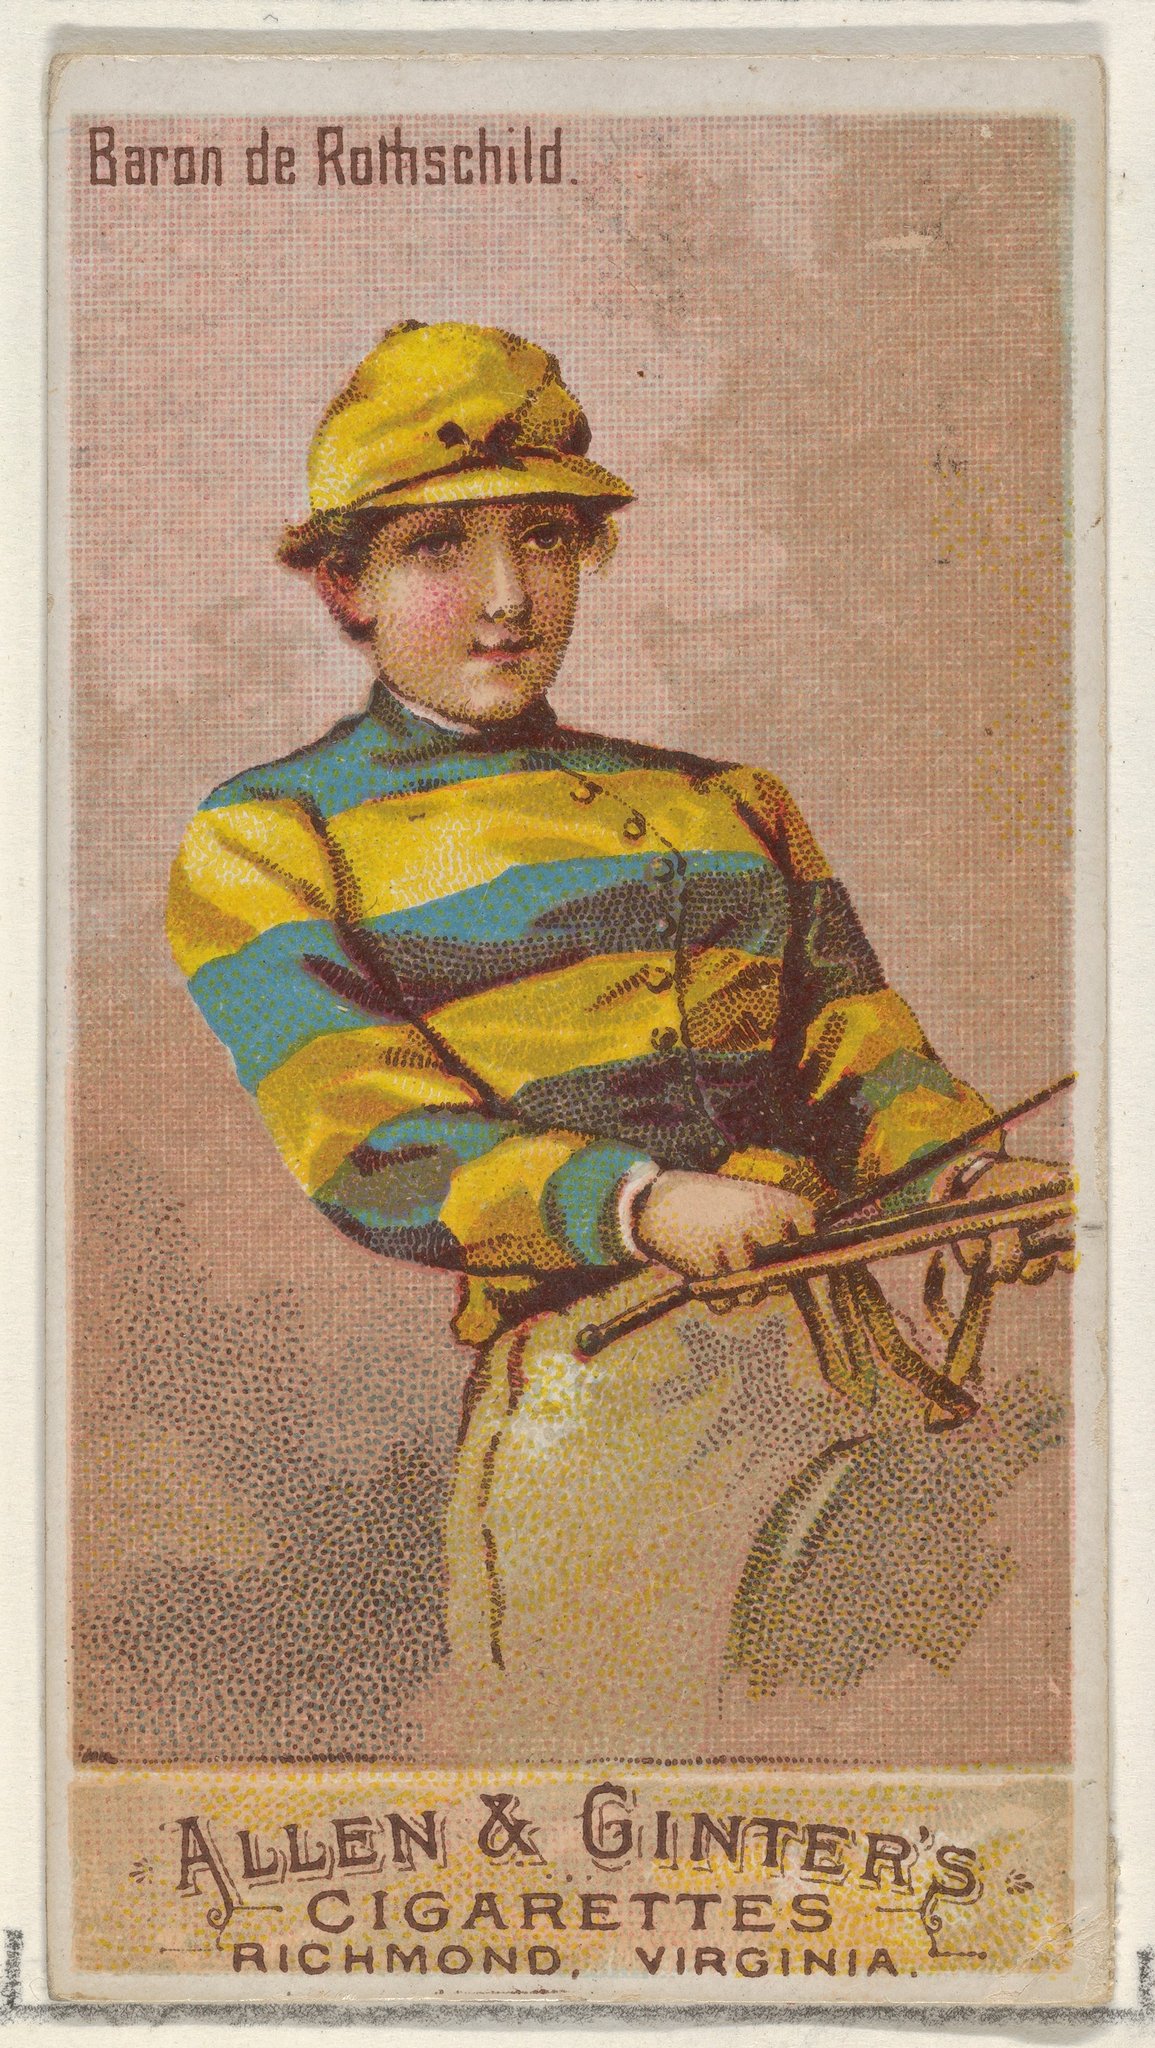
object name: print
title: Baron de Rothschild, from the Racing Colors of the World series (N22a) for Allen & Ginter Cigarettes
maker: allen & ginter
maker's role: publisher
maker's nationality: american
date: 1888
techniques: color lithograph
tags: men,jockeys